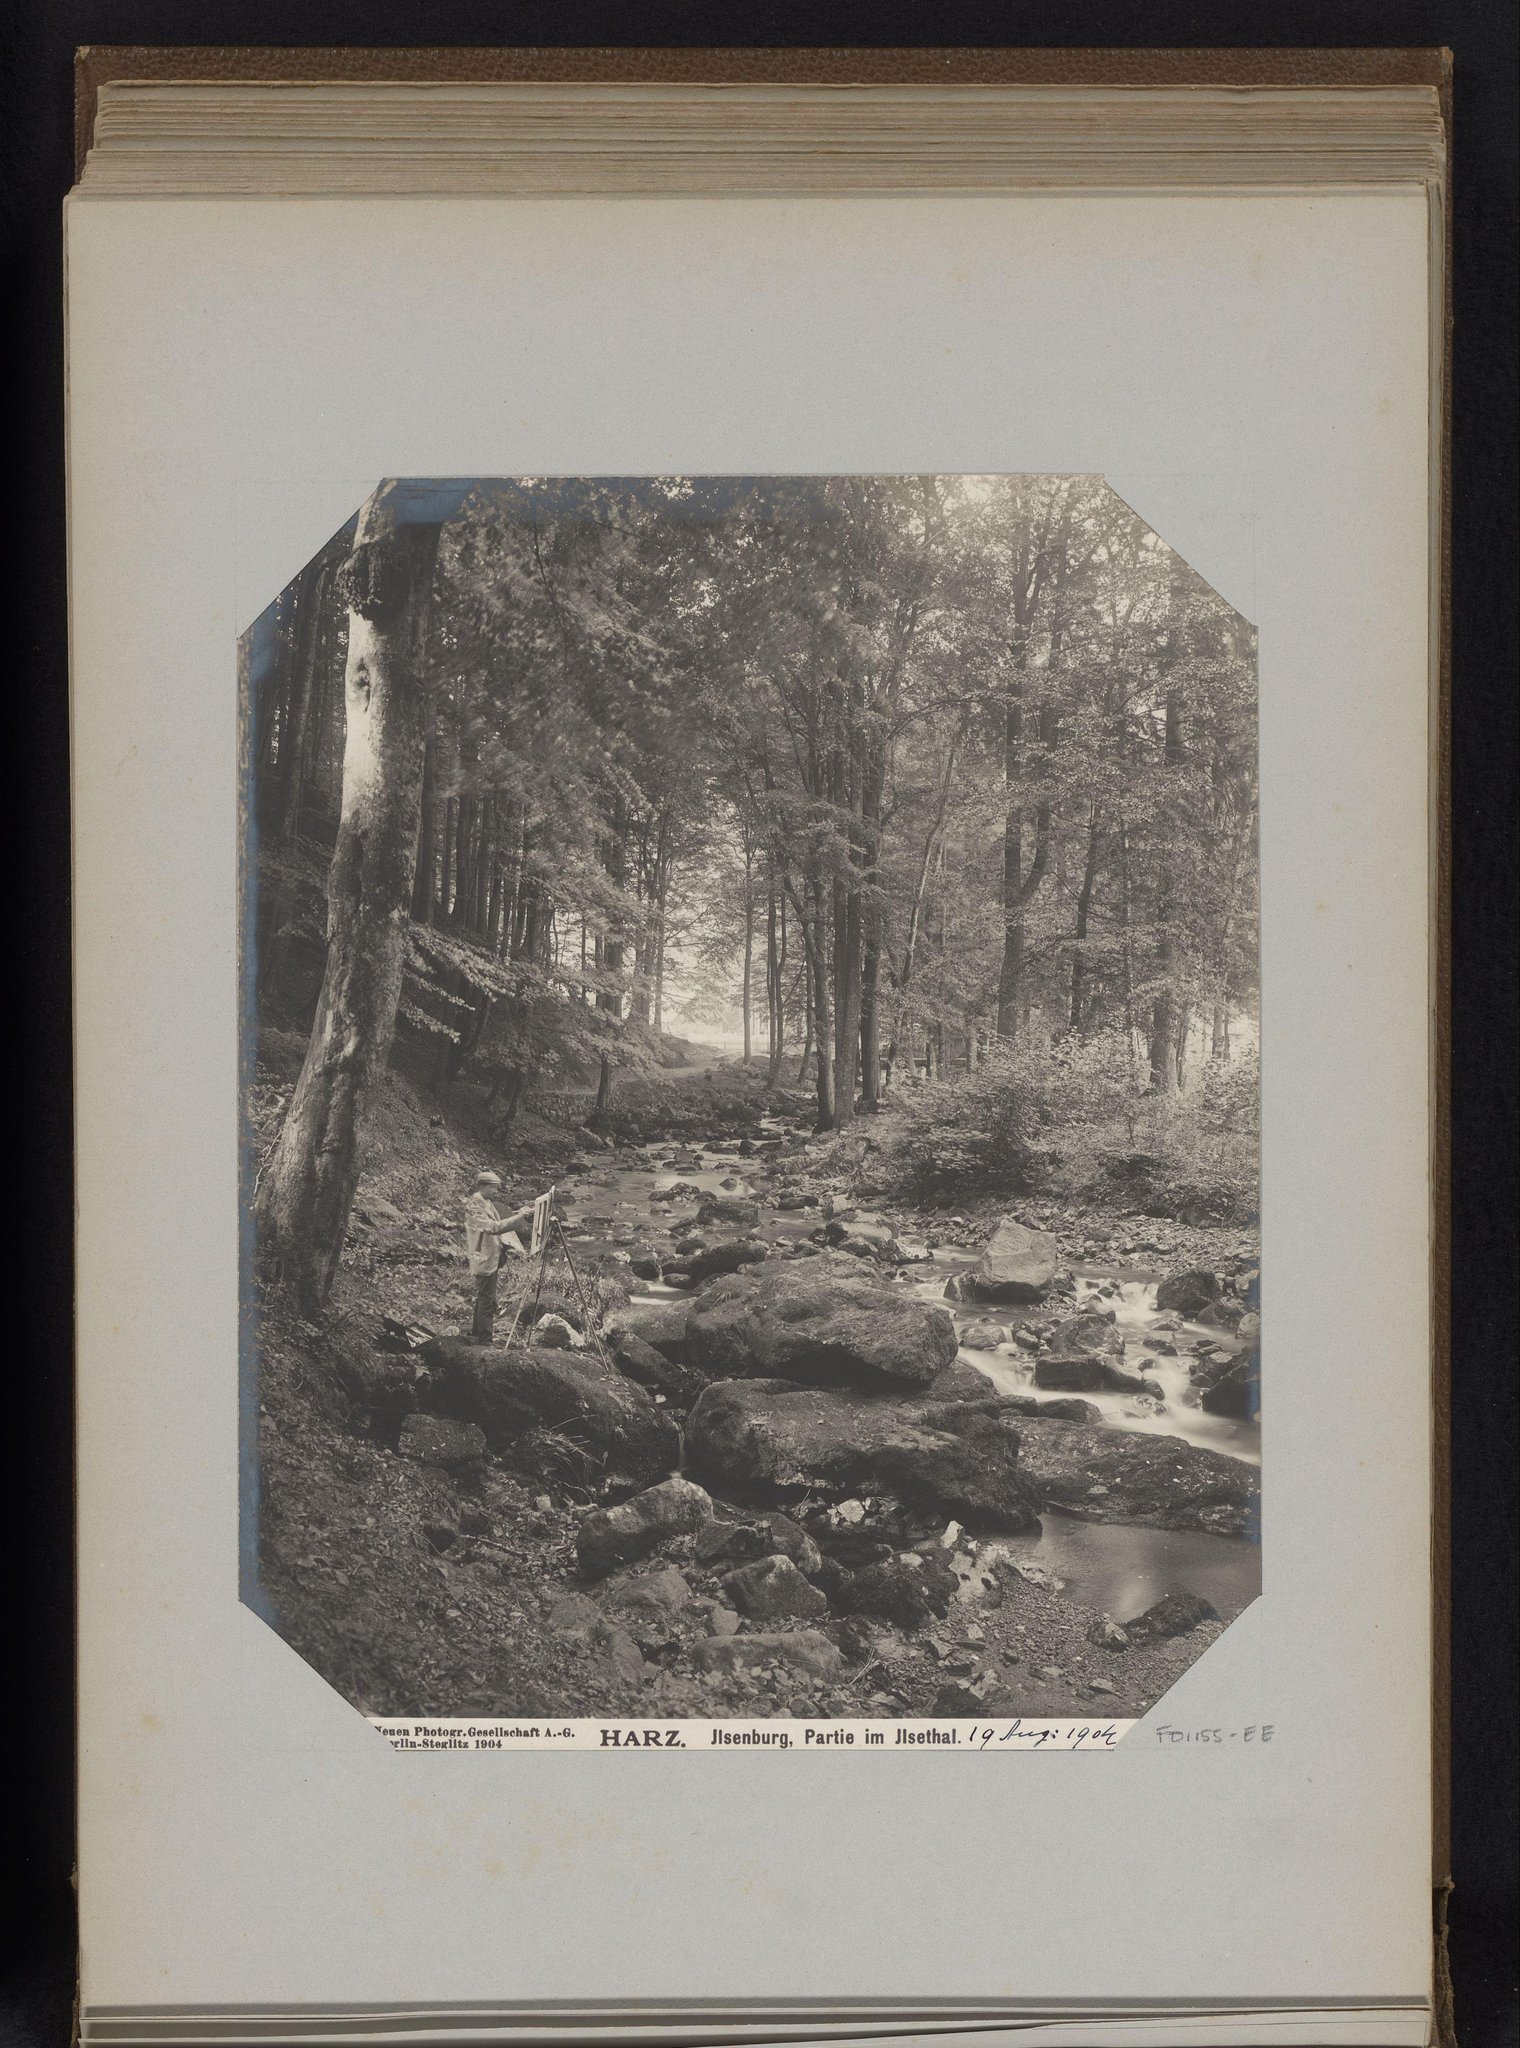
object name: album leaf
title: Schilder langs een rivier in het Ilsethal bij Ilsenburg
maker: Anonymous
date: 1904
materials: photographic support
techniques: gelatin silver print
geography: berlin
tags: working situations ~ painter - cc - out of doors, forest, wood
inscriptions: date: ‘19 Aug: 1904’, inscription: ‘Verlag der Neuen Photogr. Gesellschaft A.-G./ Berlin-Steglitz 1904/ Harz. Ilseburg, Partie im Ilsethal/ 1643’